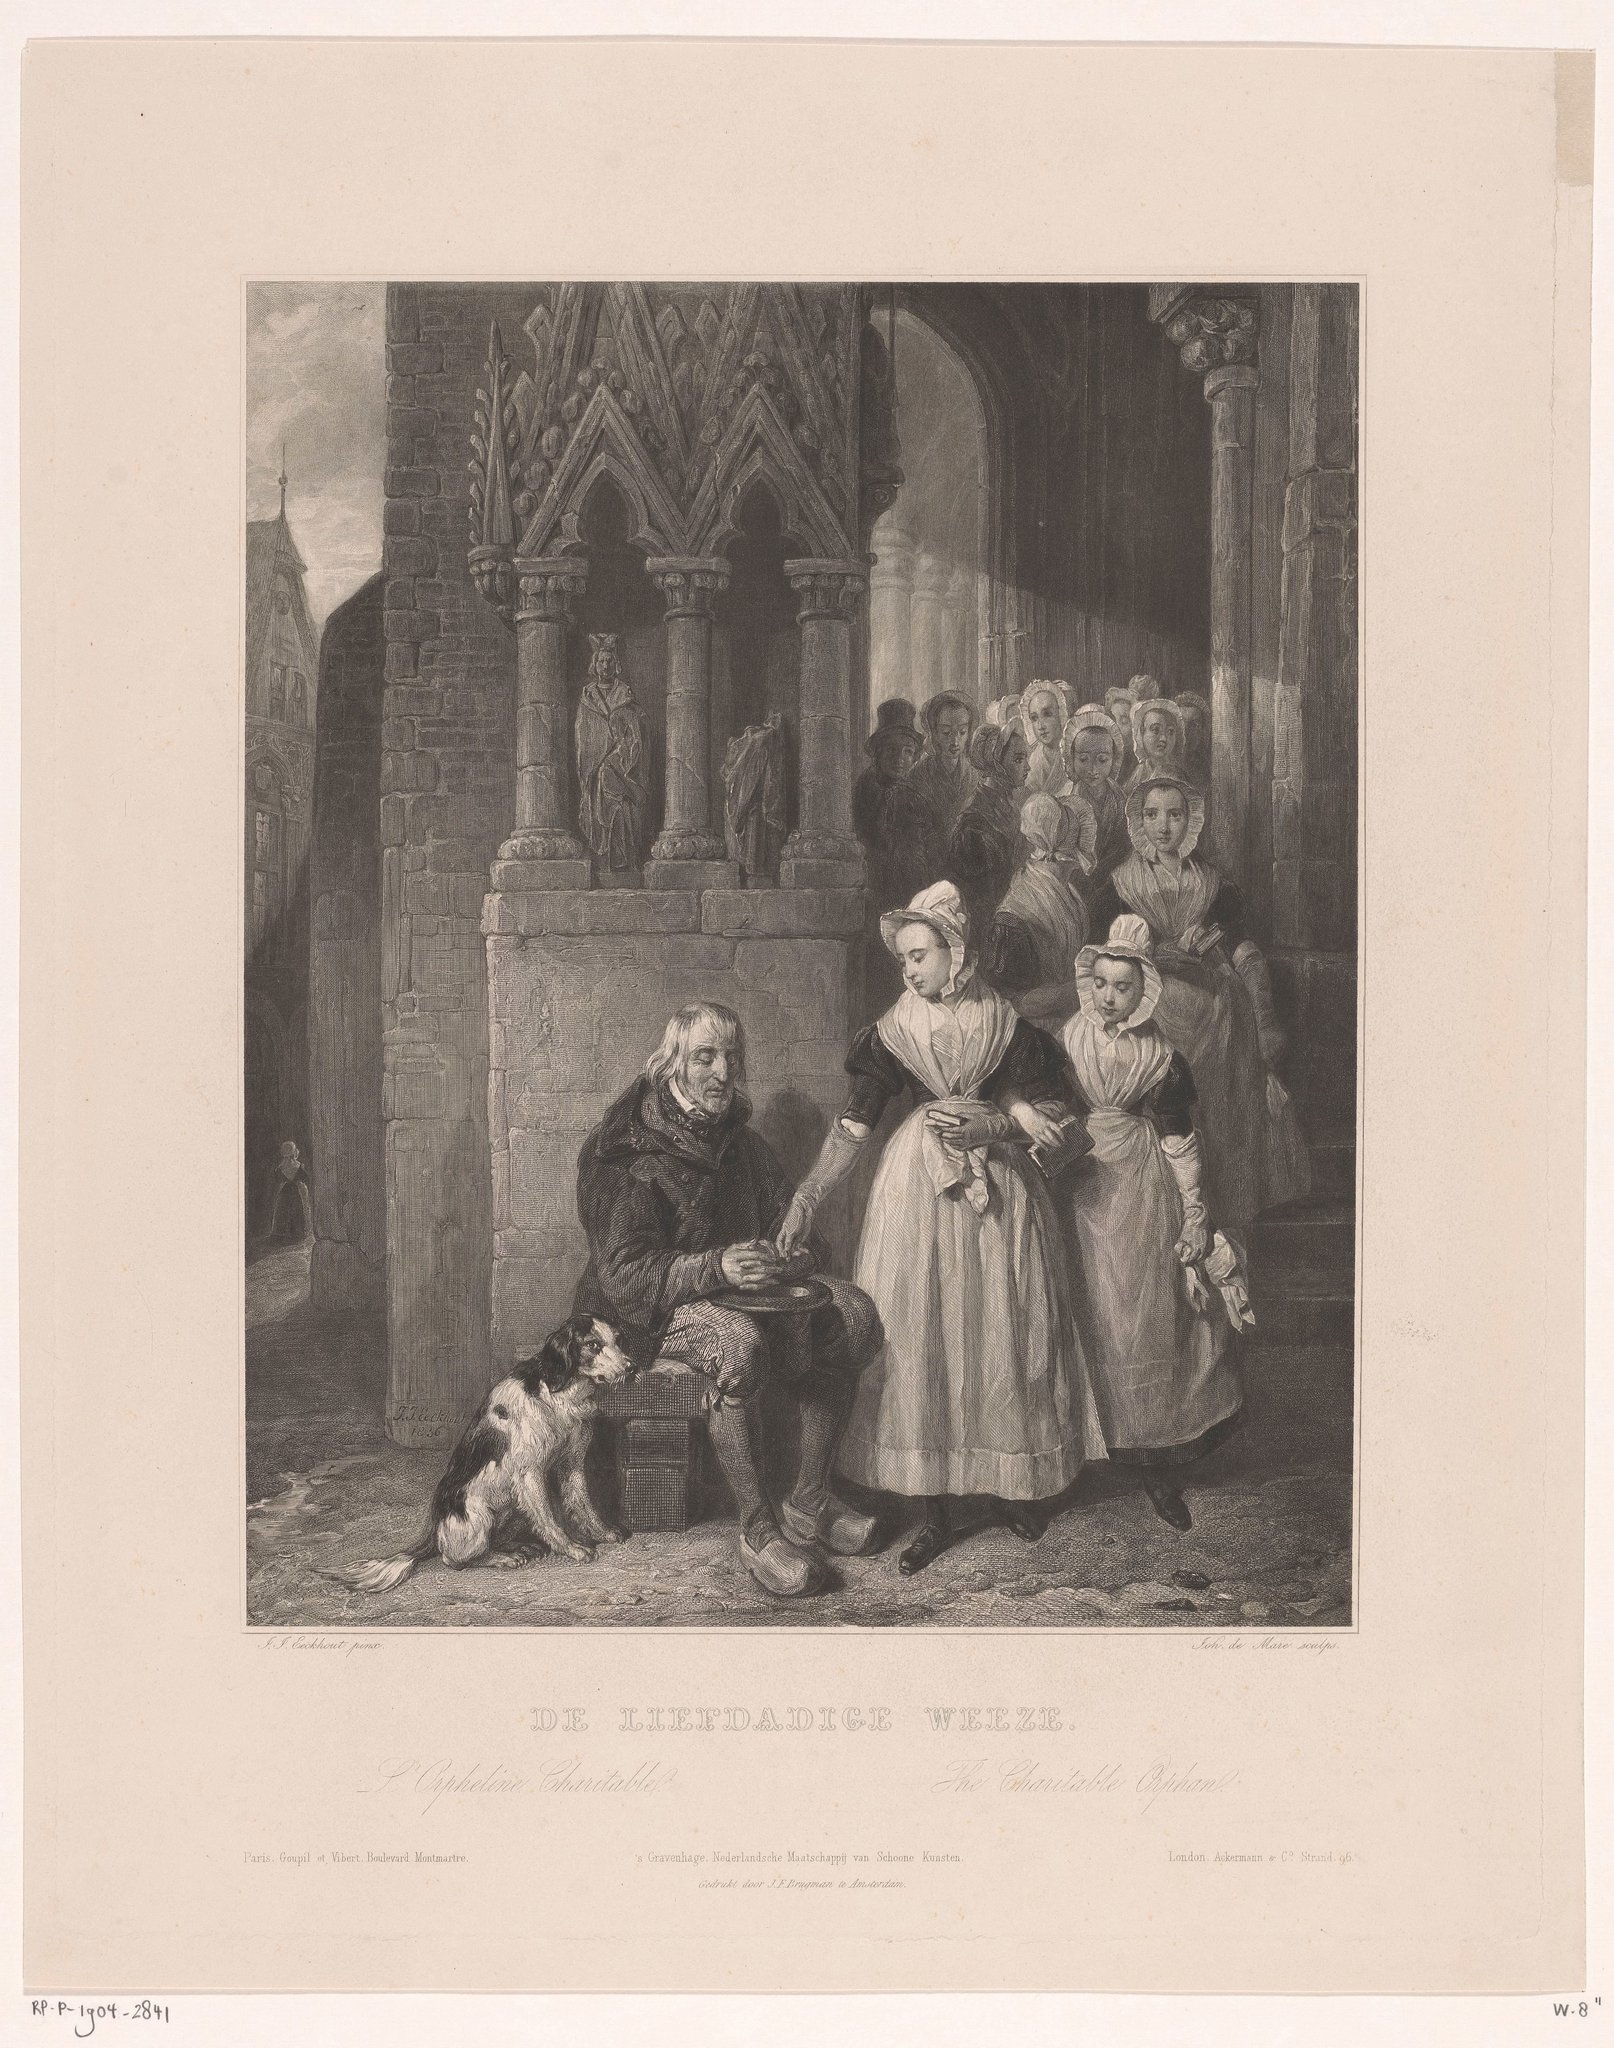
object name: print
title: Weesmeisje geeft aalmoes aan en bedelaar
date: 1840-1843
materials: paper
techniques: engraving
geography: amsterdam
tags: parts of church exterior and annexes: portal, beggar, giving alms; collection, orphans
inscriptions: collector's mark: Lugt 2228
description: Bij het uitgaan van een kerkmis lopen vele weesmeisjes door een kerkportaal. De voorste van hen geeft een aalmoes aan een bedelaar met naast hem een hond.